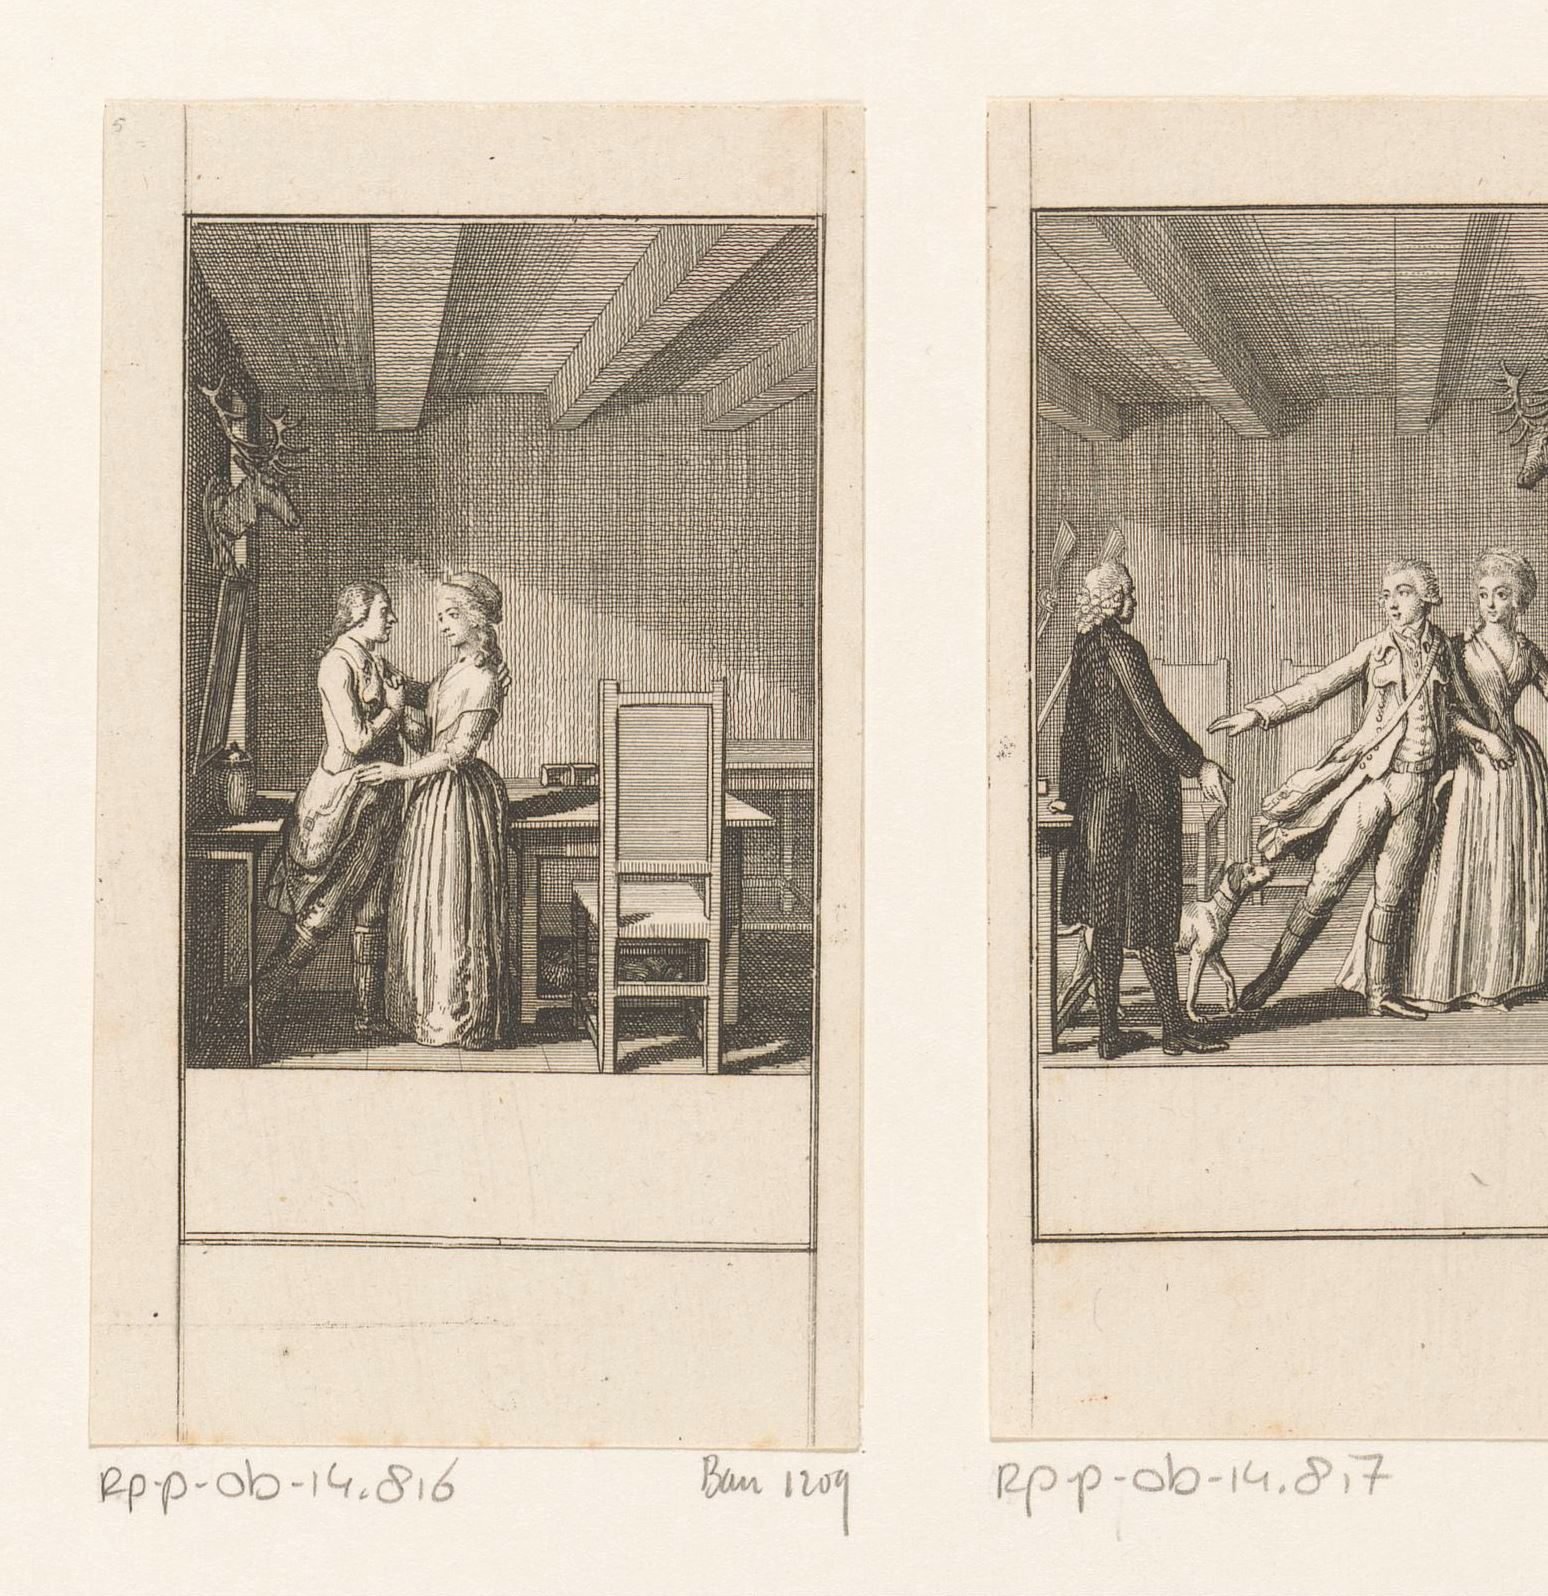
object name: print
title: Anton en Friedrike eindelijk alleen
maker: daniel nikolaus chodowiecki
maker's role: draughtsman, print maker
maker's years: 1726-1801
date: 1786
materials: paper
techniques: etching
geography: berlin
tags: literature, (lovers) embracing each other, 'symplegma', lovers' meeting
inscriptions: collector's mark: Lugt 2228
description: Vervaardigd voor August Wilhelm Ifflands 'Die Jäger'. Latere staat gebruikt voor: Berliner genealogischen Calender auf das Jahr 1787. Berlijn: s.n., 1786.